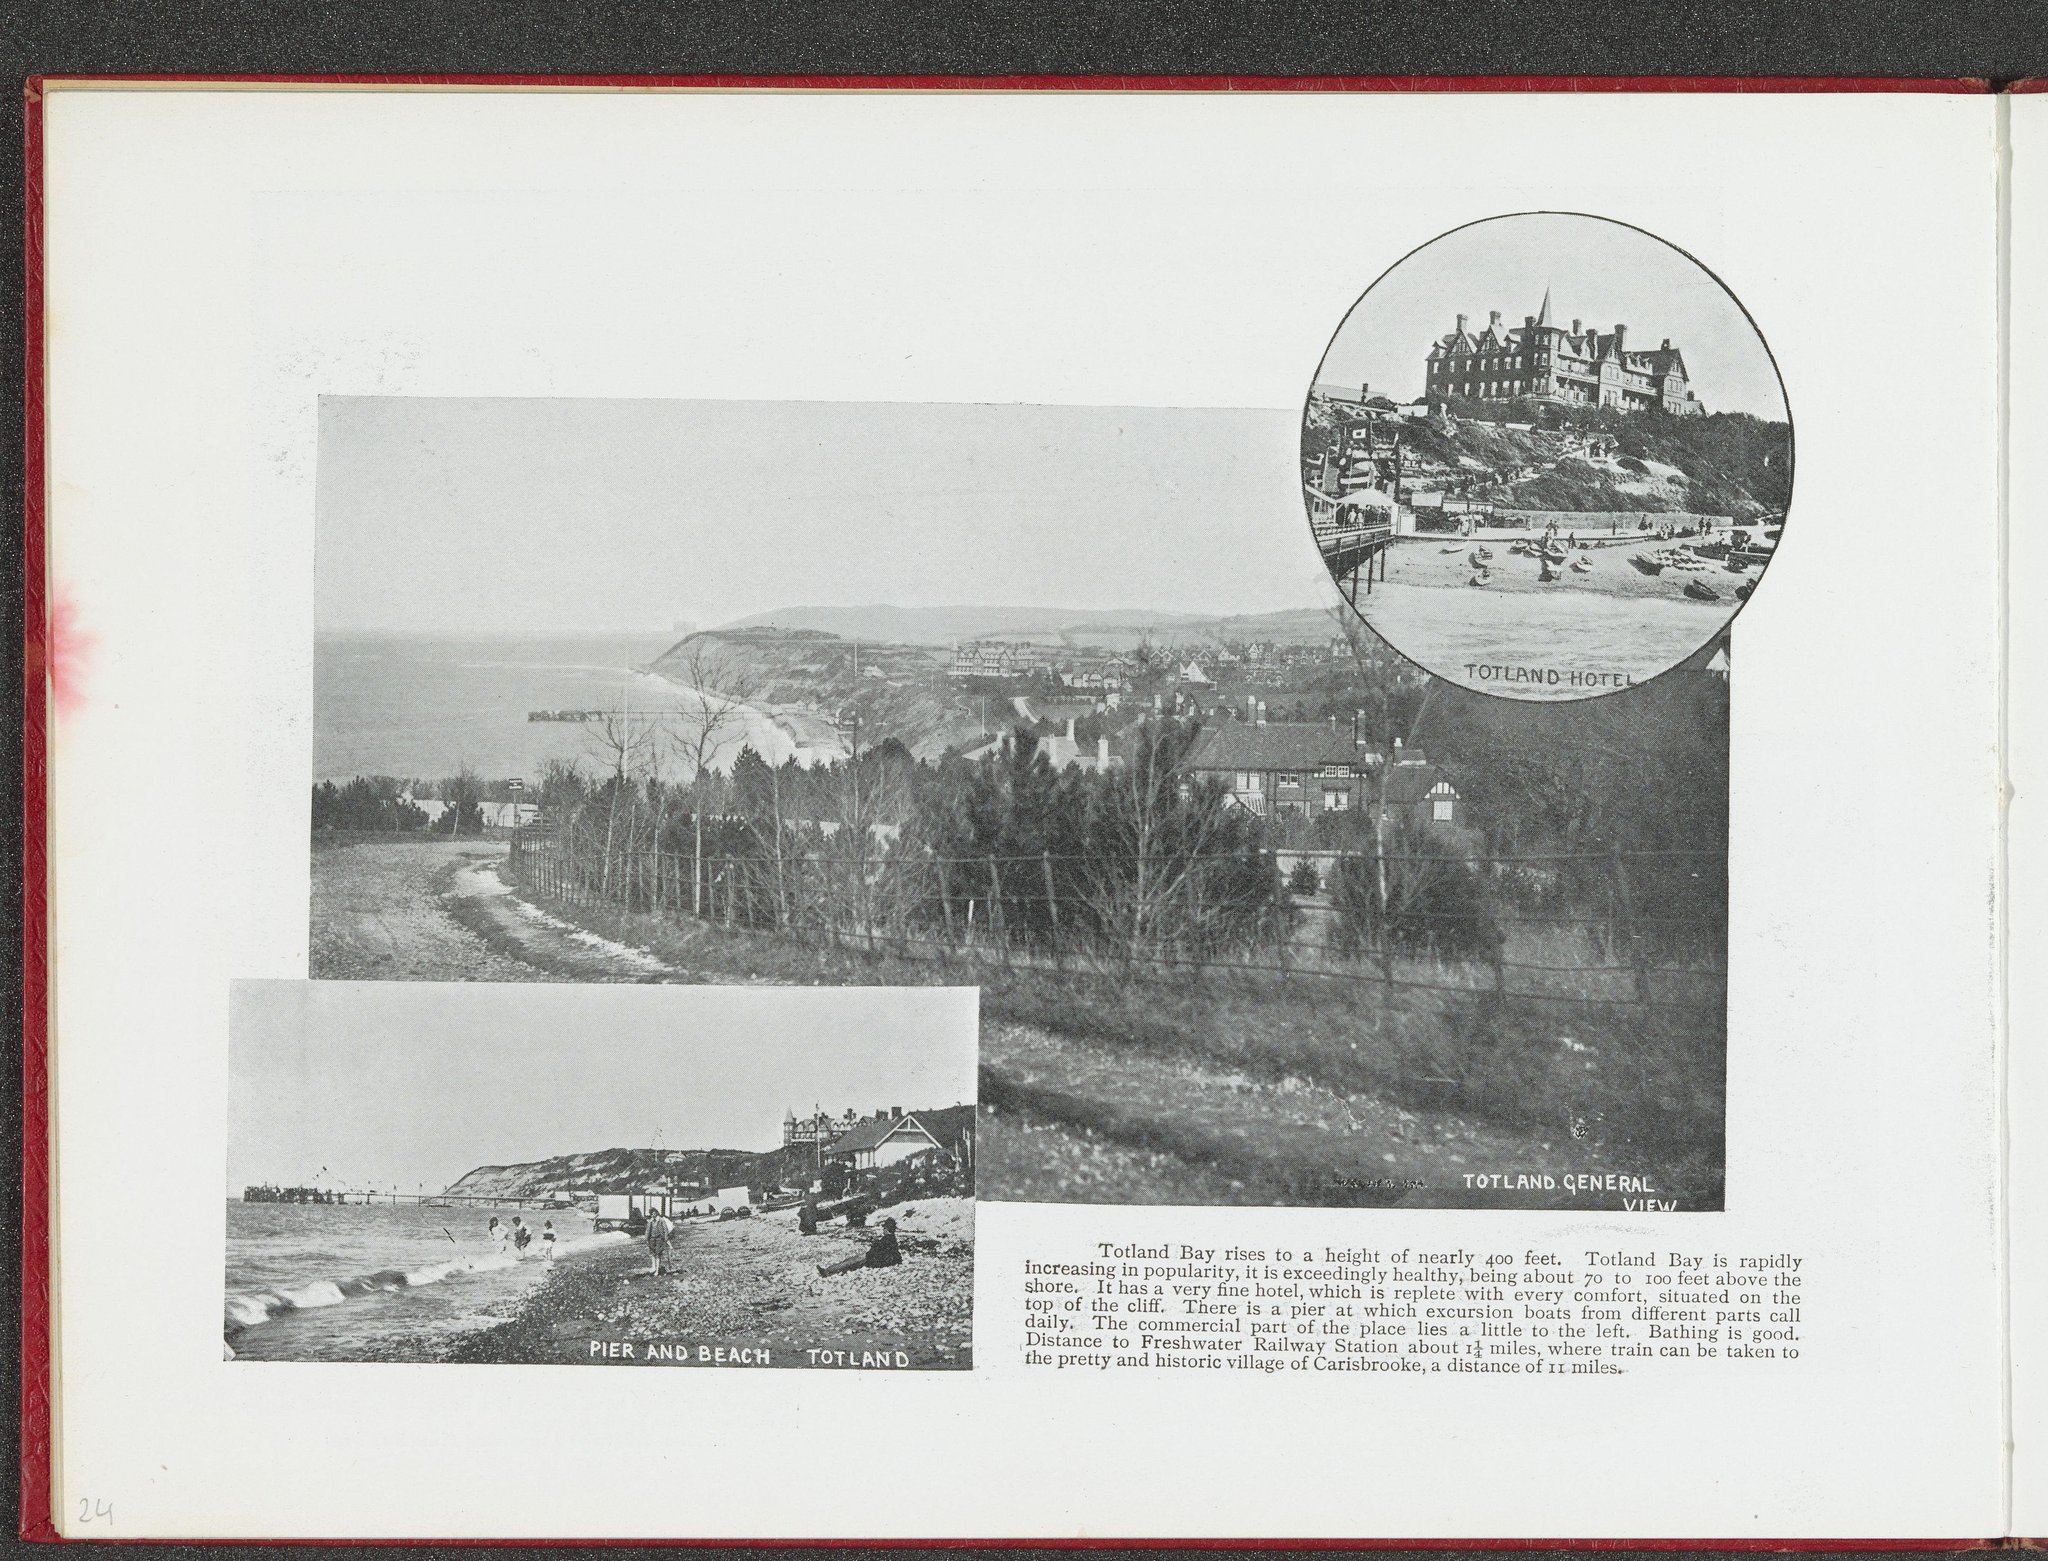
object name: photograph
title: Totland en Totland Bay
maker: Anonymous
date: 1897-1930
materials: paper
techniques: printing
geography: isle of wight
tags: beach (as place of recreation), gulf, bay (+ landscape with figures, staffage), travelling; tourism, coastal cliff or crag, hotel, hostelry, inn, isle of wight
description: Pagina 24 met 3 foto's van het strand en een hotel van Totland, een overzicht van Totland Bay en een bijschrift. Onderdeel van Fotografische reisreportage van het eiland Wight.